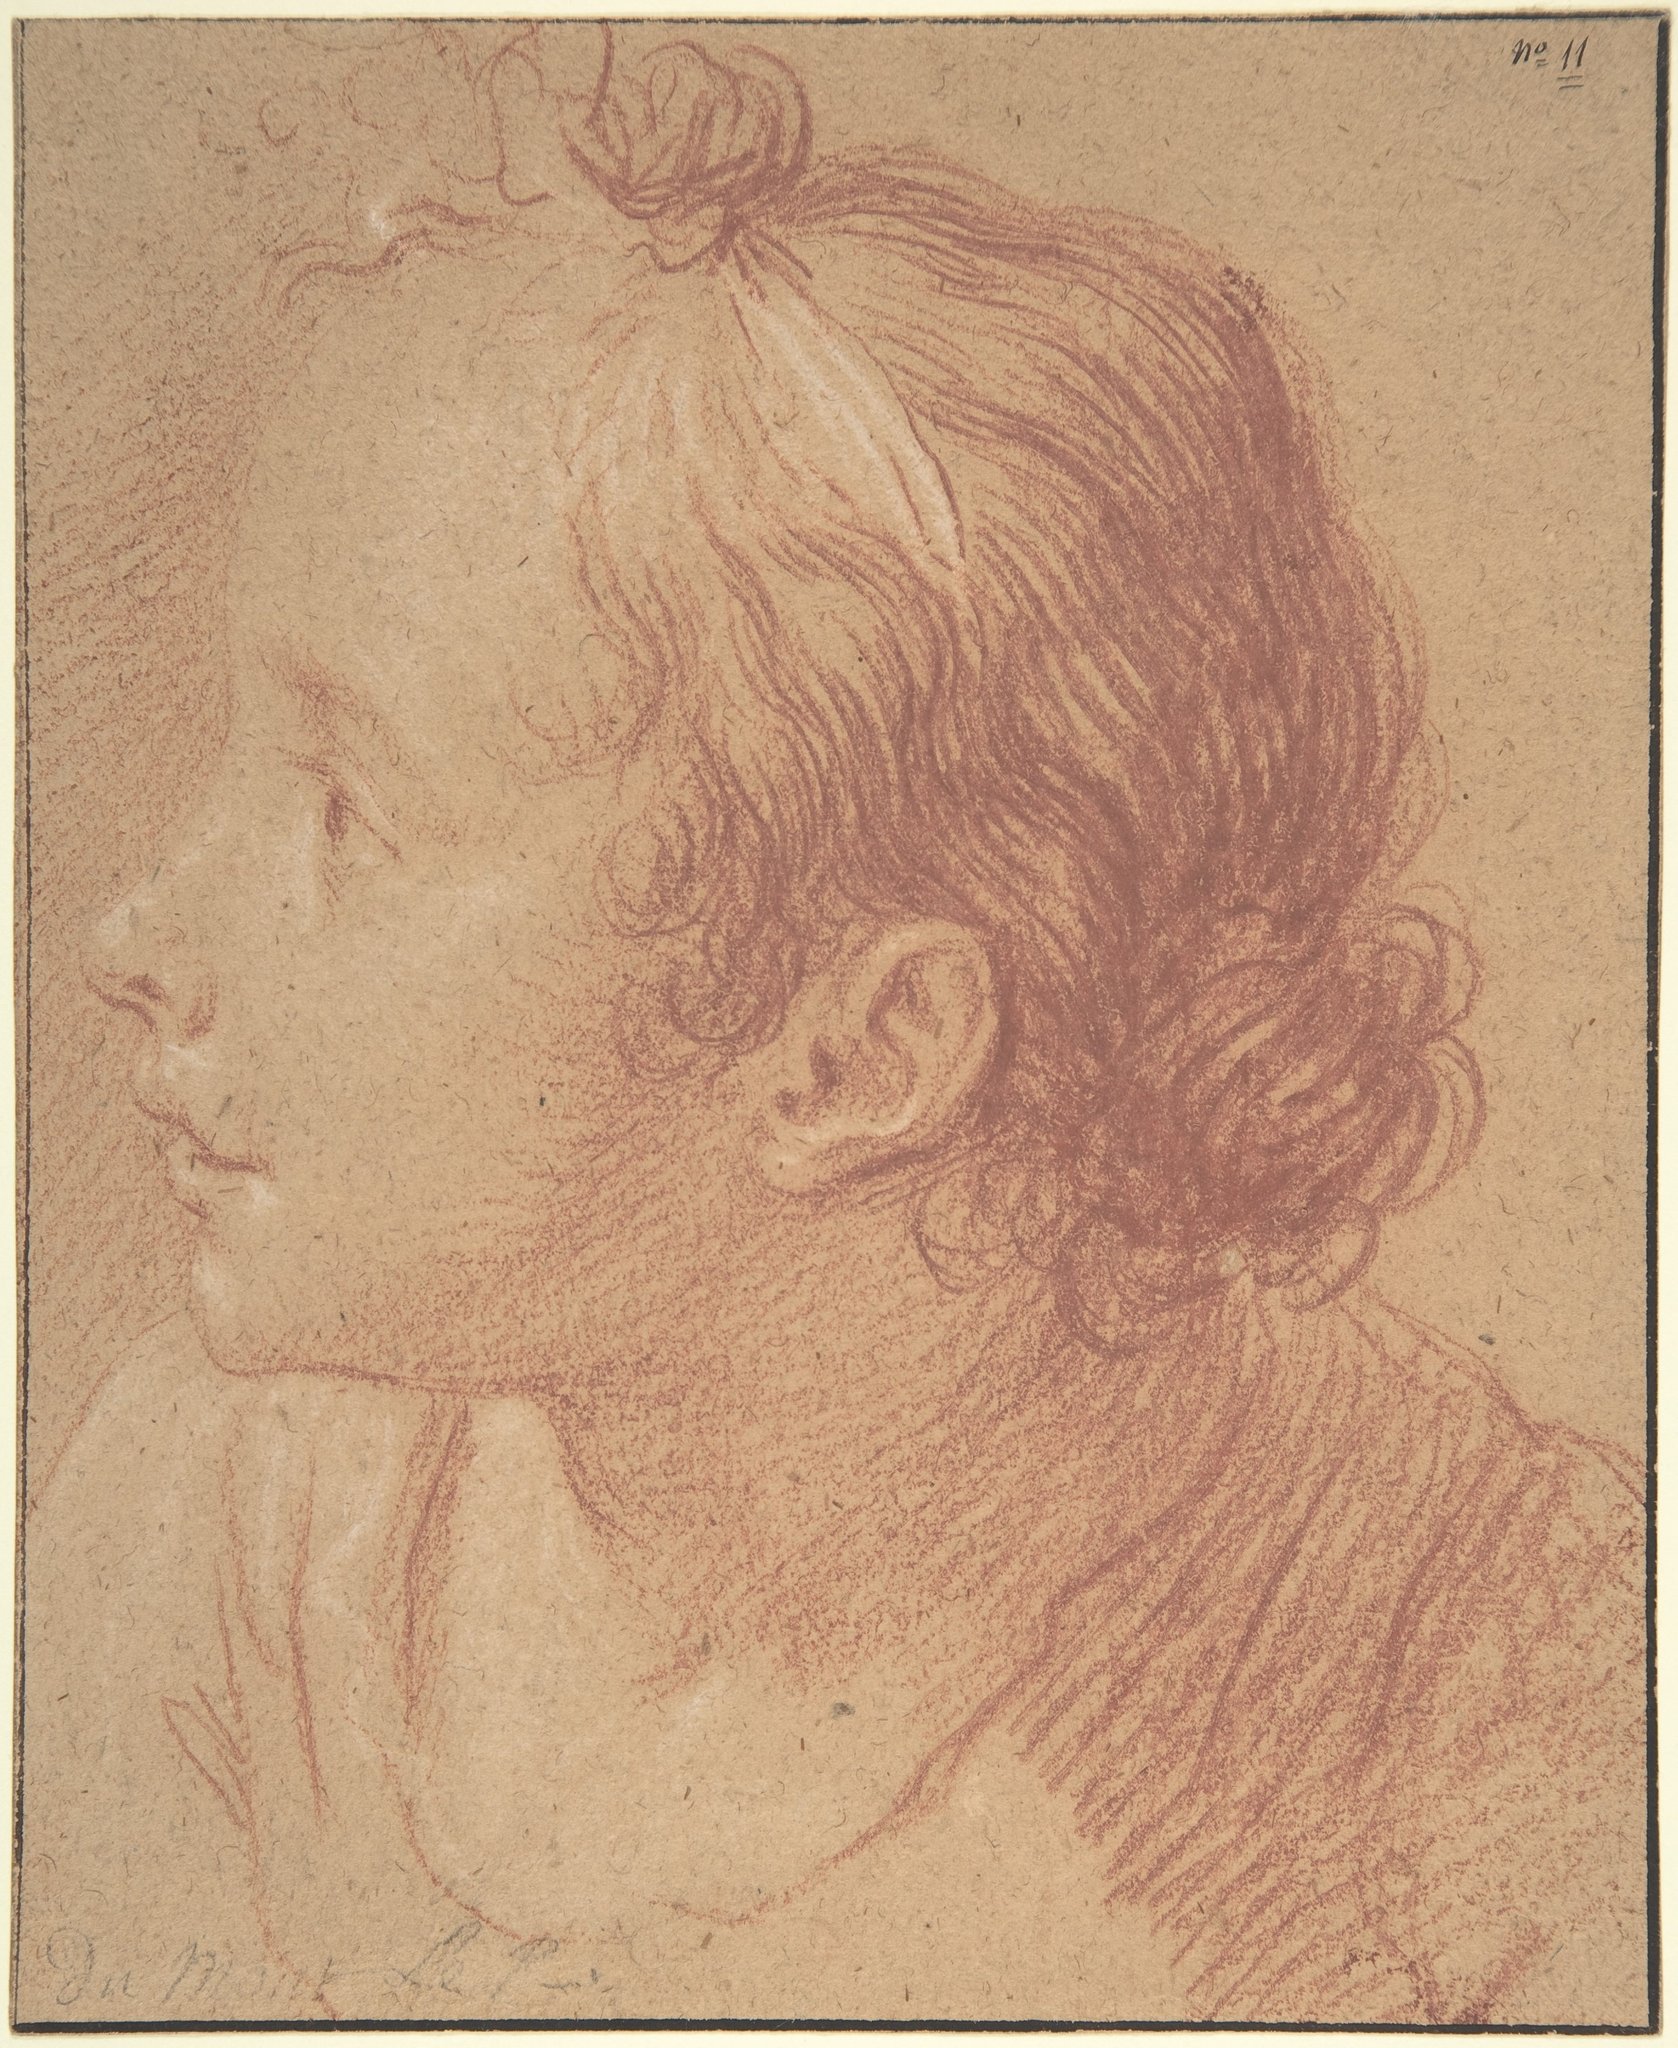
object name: drawing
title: Head of a Young Girl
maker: jacques dumont, called le romain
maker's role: artist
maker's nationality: french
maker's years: 1701-1781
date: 1701-1800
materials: chalk, paper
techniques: heightening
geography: france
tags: heads,girls